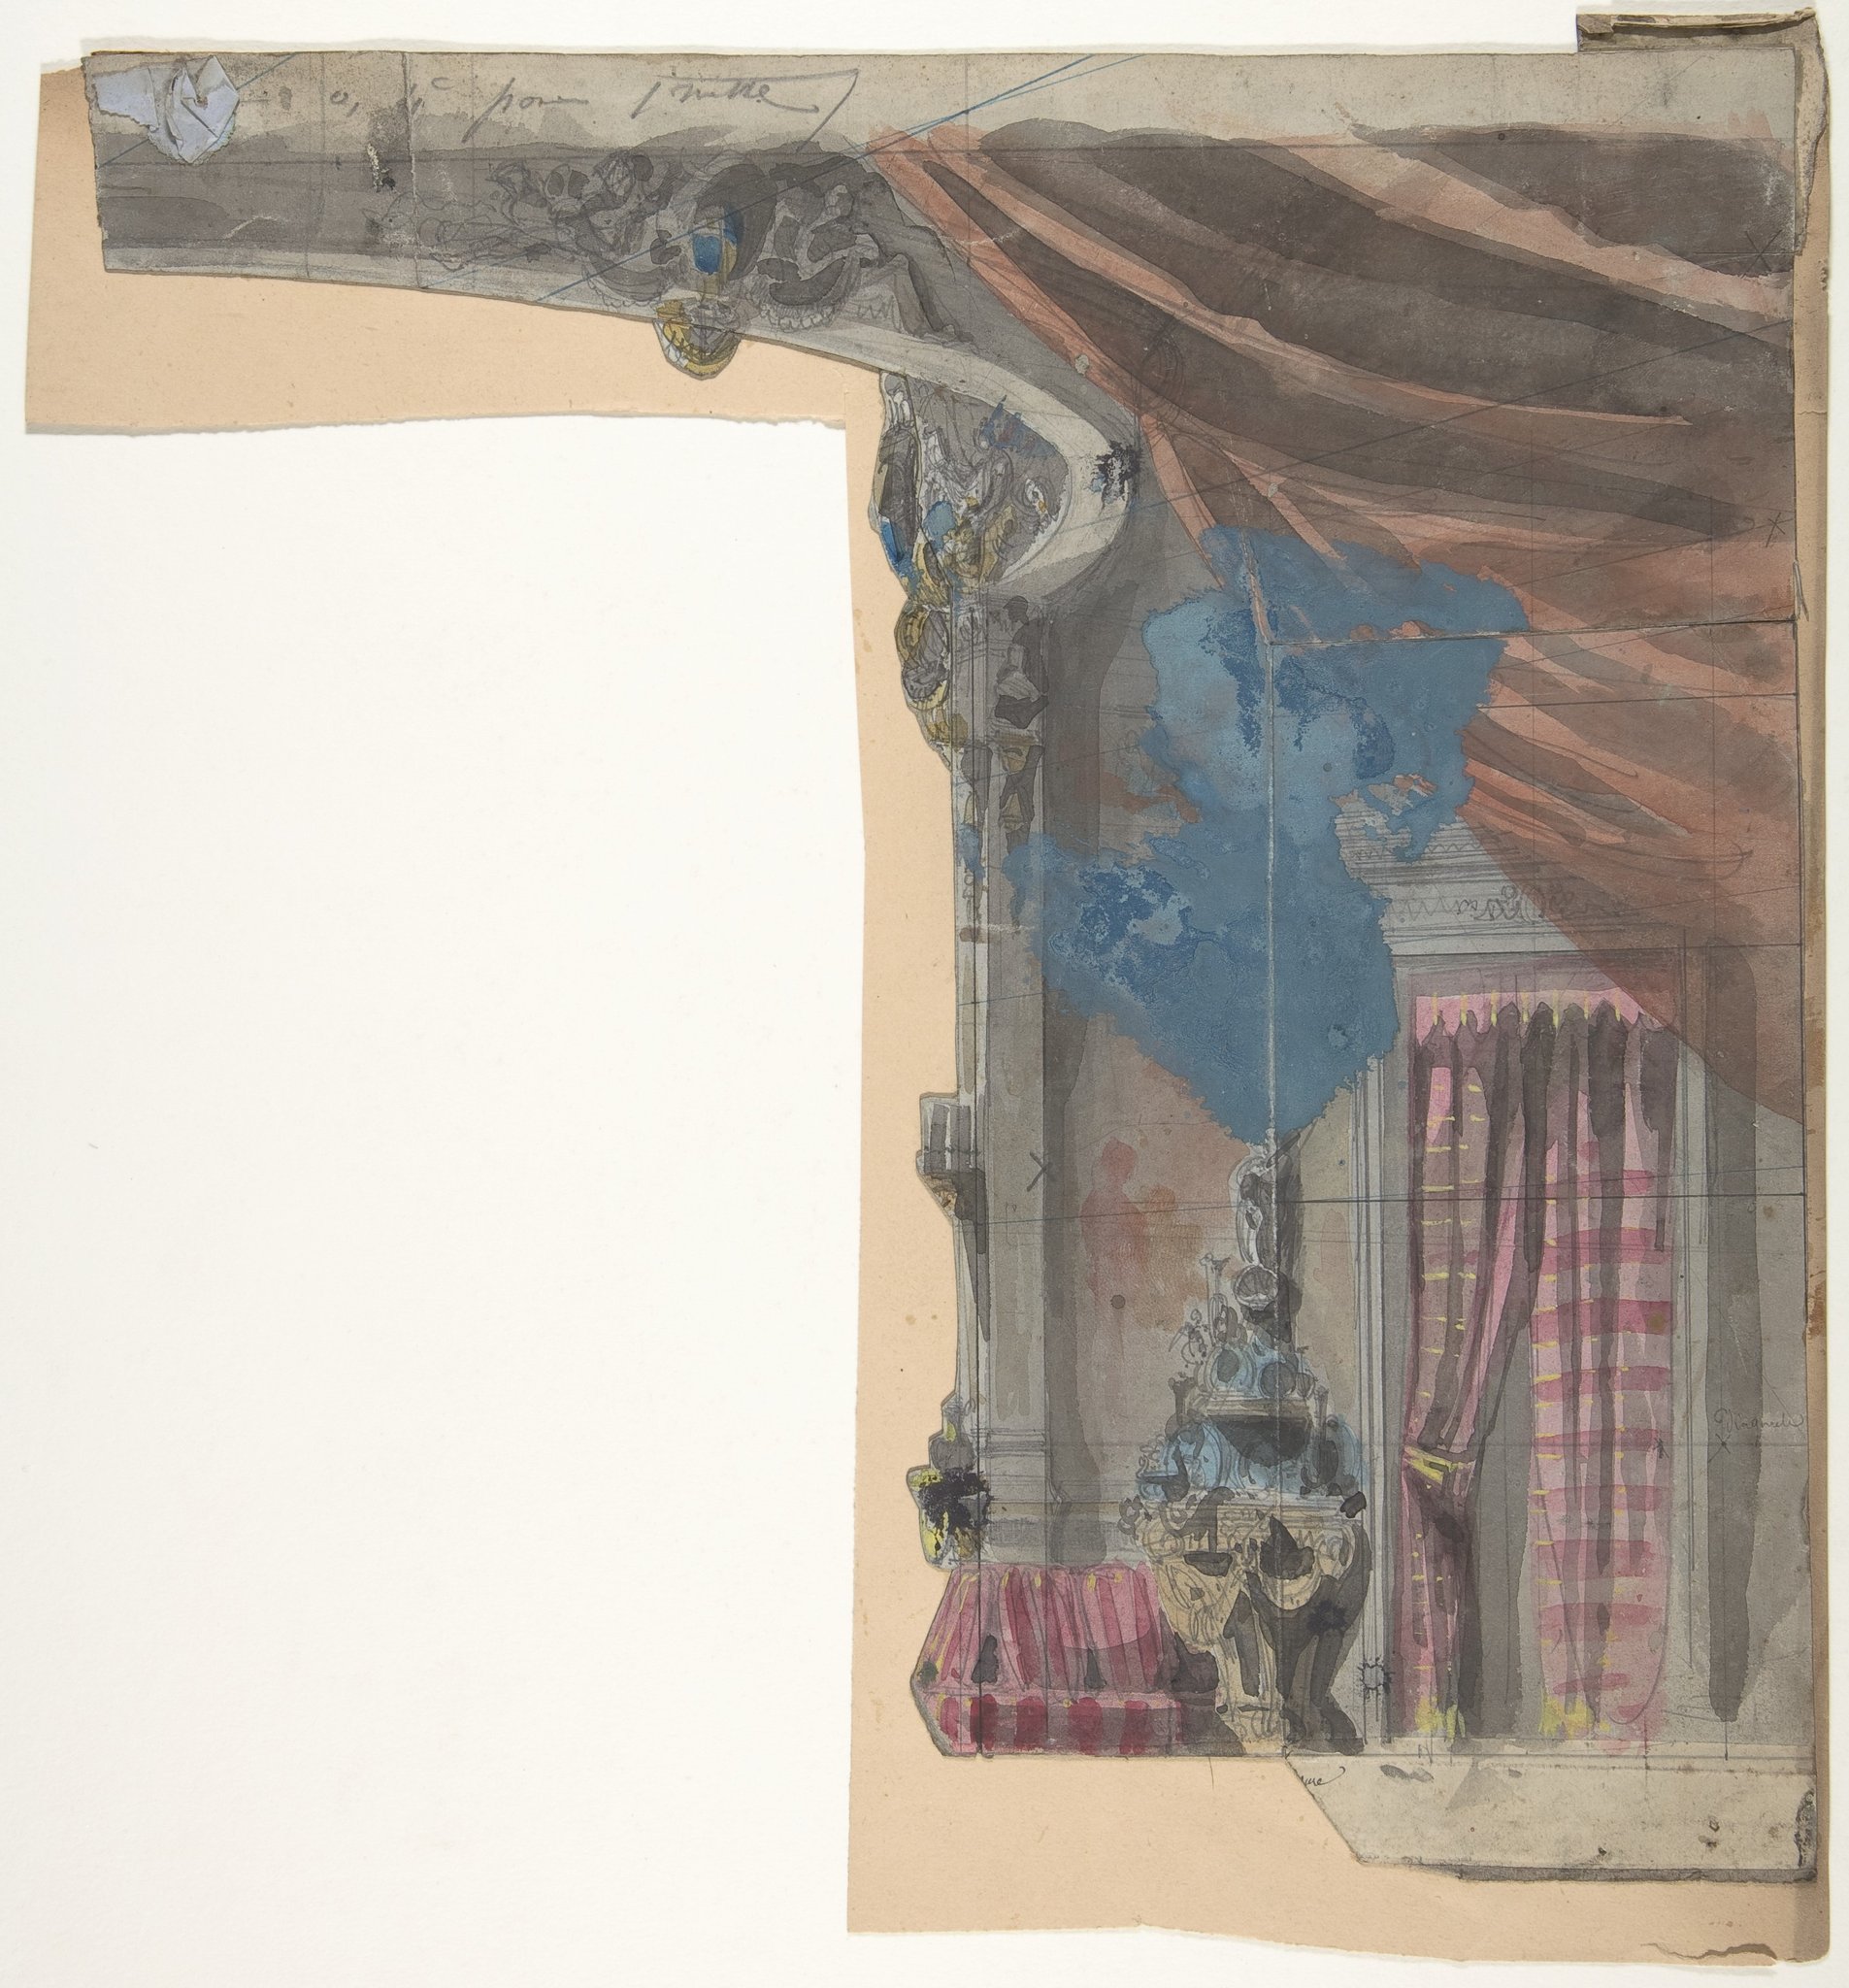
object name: drawing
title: Design for a Stage Set at the Opéra, Paris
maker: eugène cicéri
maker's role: artist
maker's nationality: french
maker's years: 1813-1890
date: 1828-1890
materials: gouache, graphite, watercolor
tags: theatre,curtains,stage design